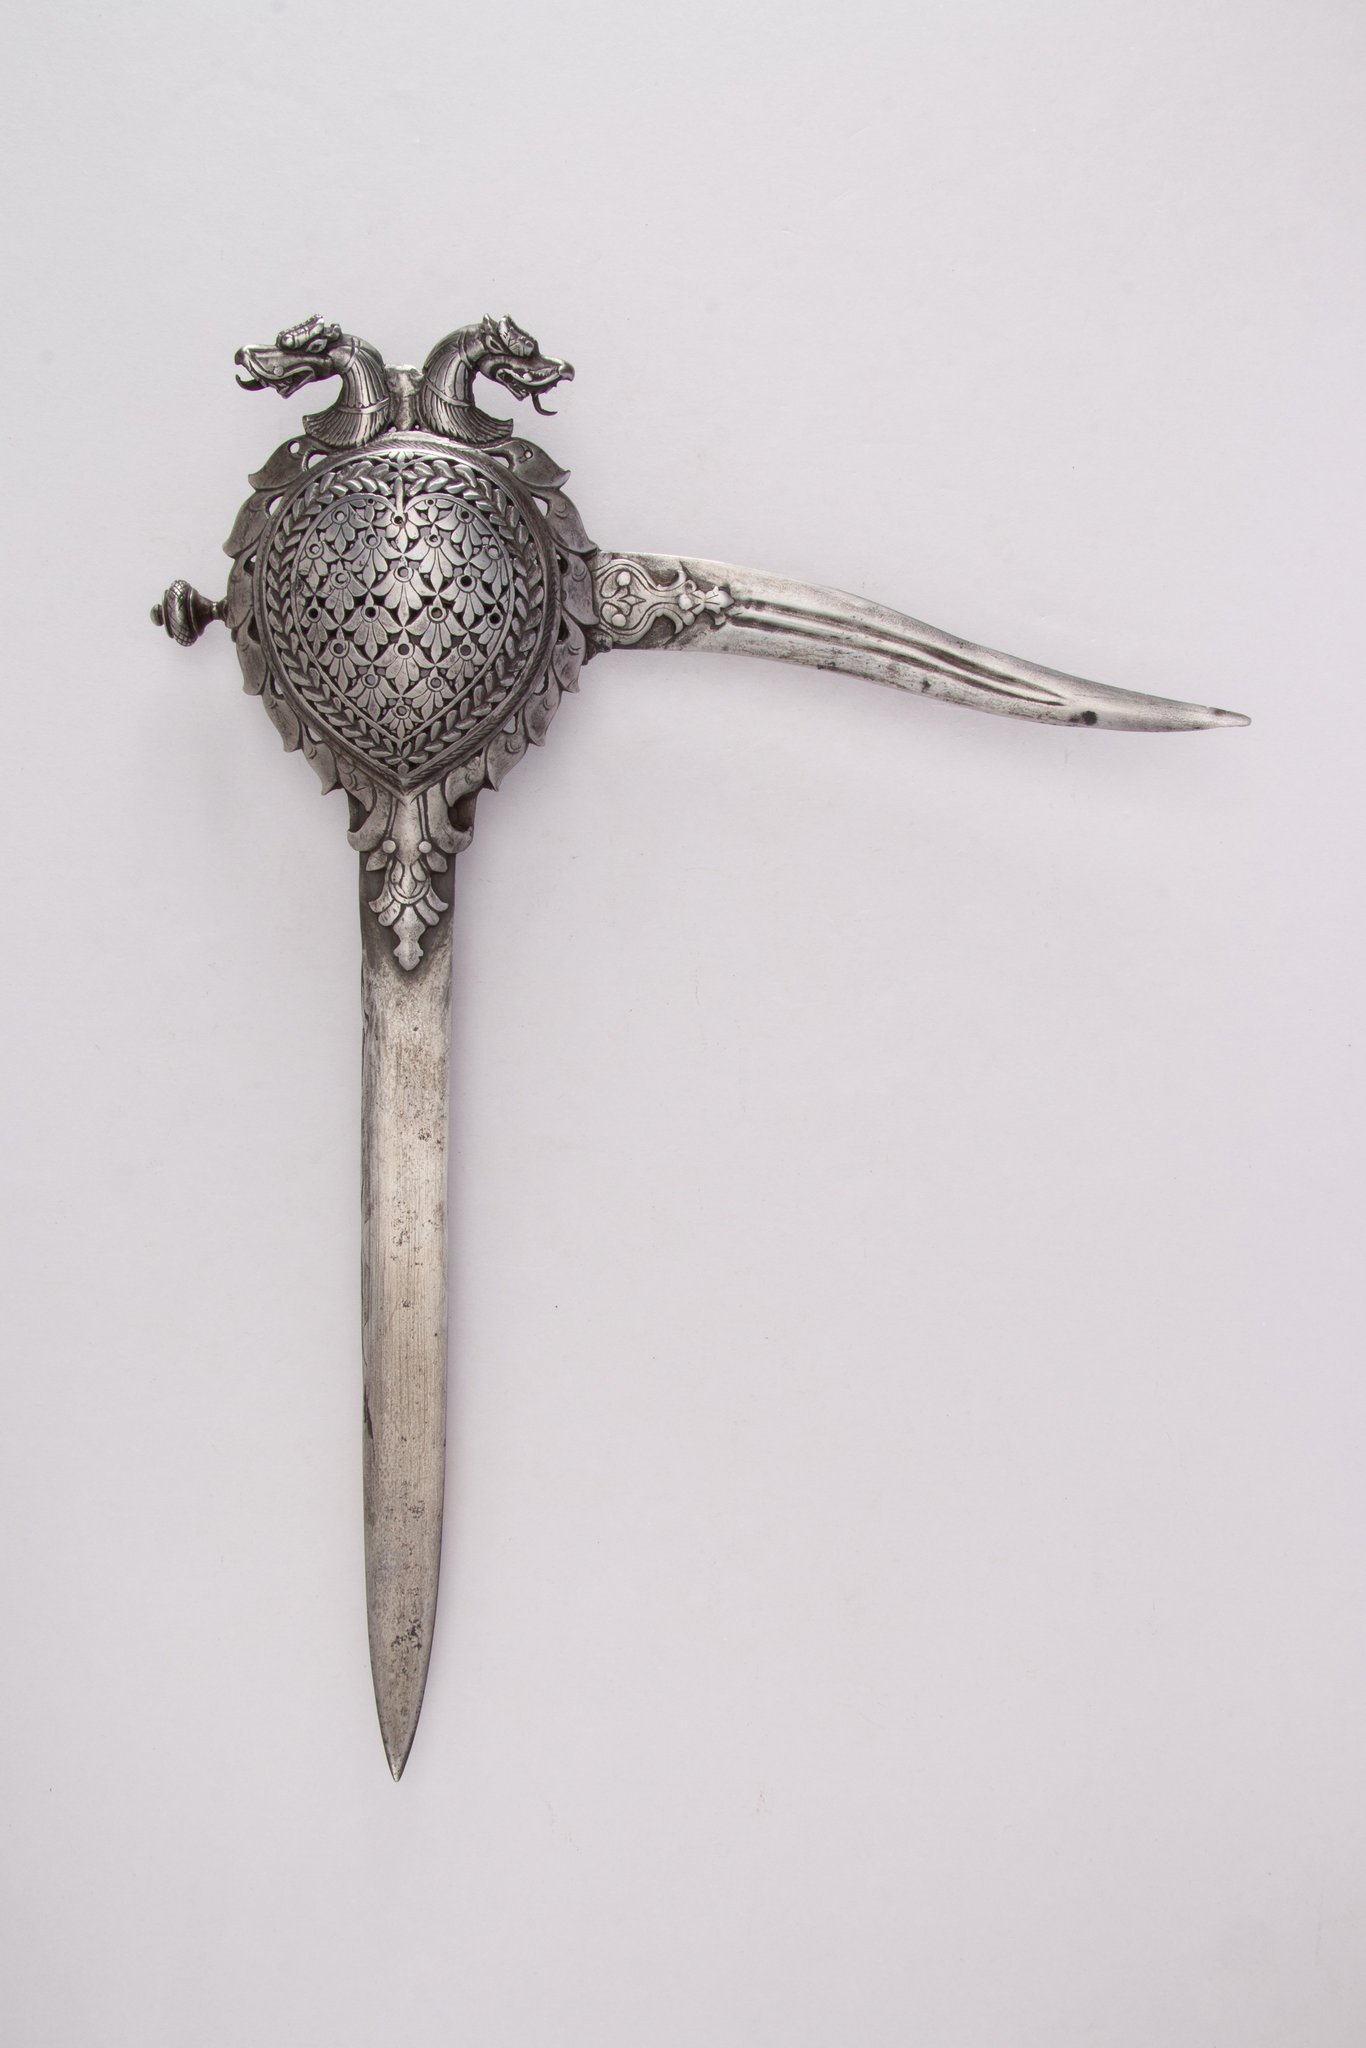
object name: dagger katar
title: Dagger (Katar)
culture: indian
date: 1601-1633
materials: steel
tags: dragons